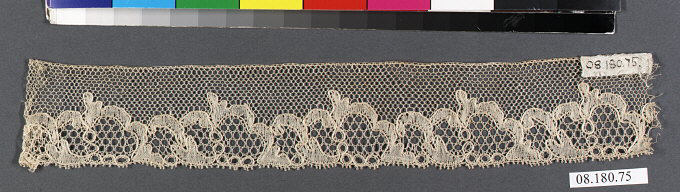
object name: fragment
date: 1801-1900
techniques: lace